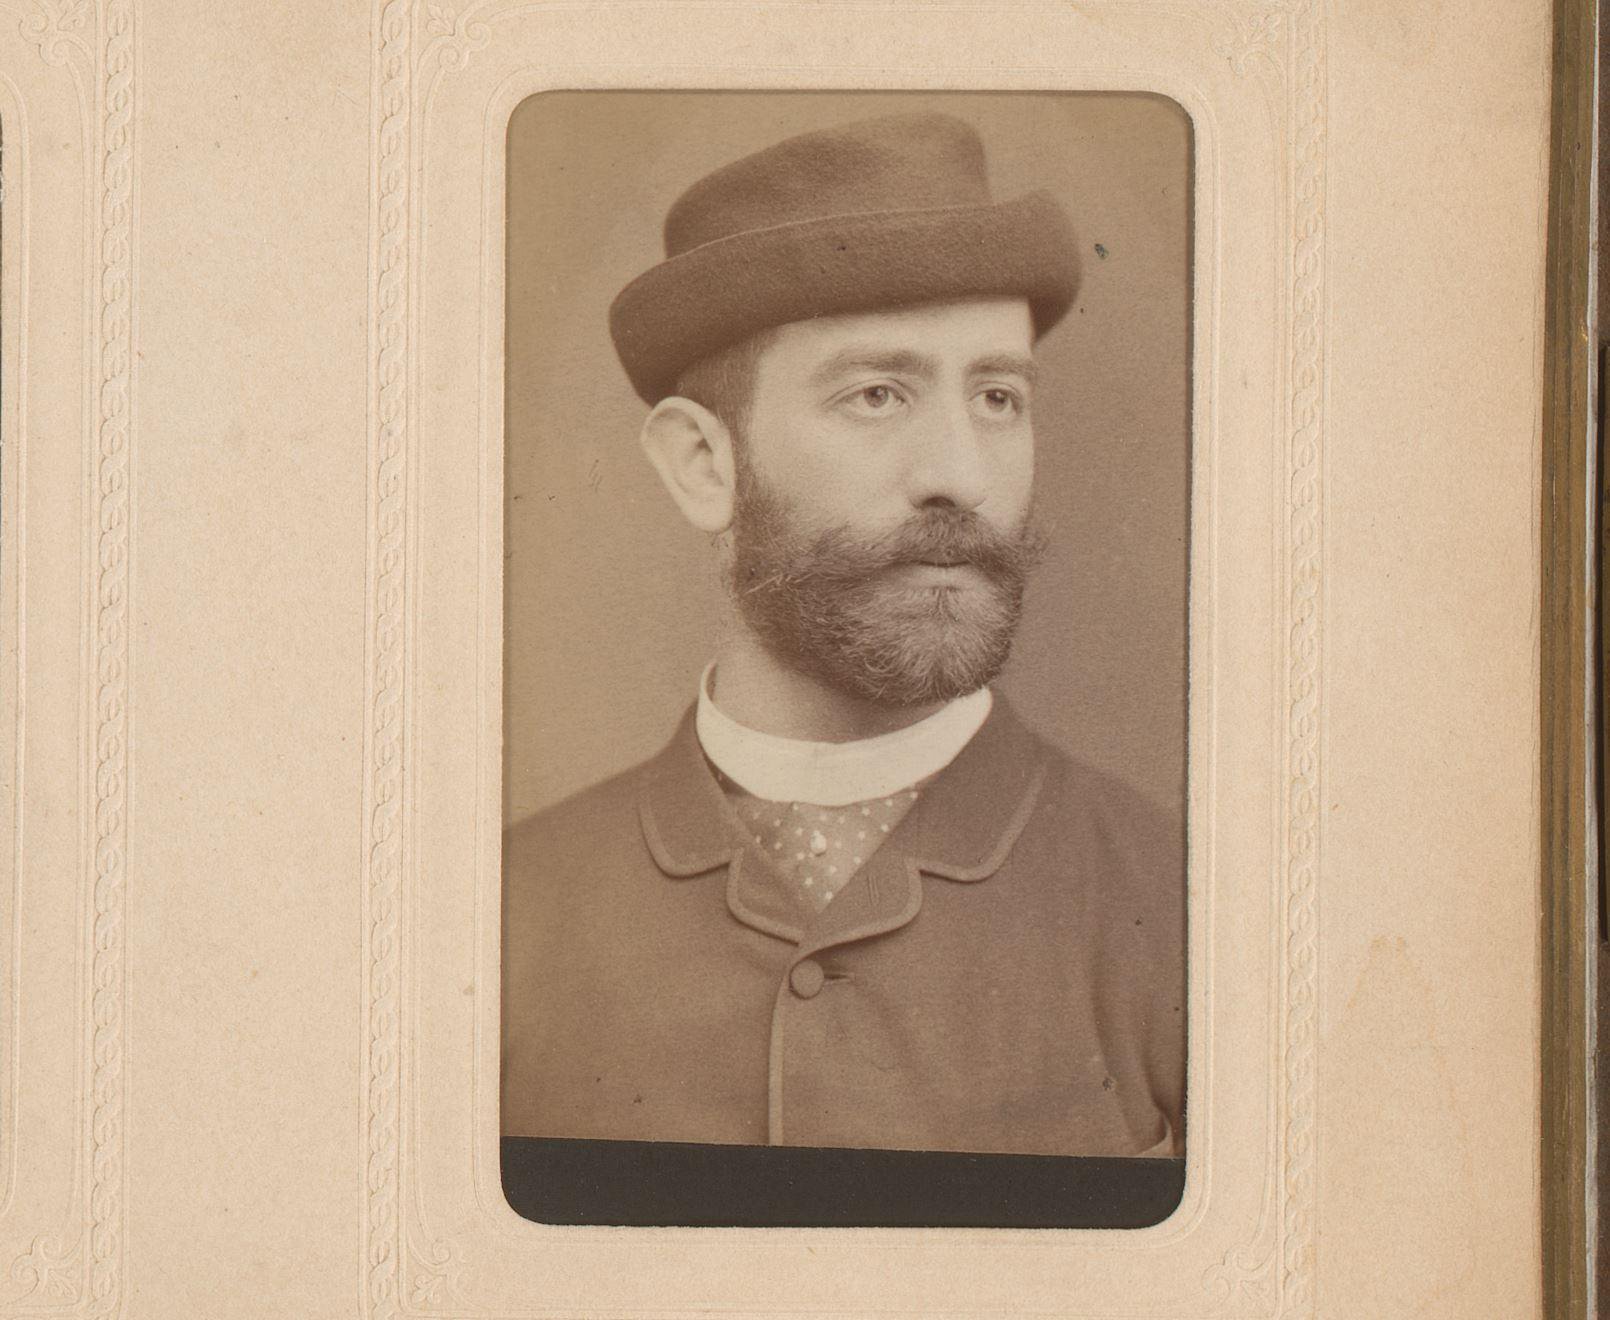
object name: carte de visite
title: Portret van een man met snor, baard en hoed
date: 1860-1900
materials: cardboard, photographic support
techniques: albumen print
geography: prague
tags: moustache, historical persons, head-gear: hat, beard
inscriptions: inscription: ‘VIRIBUS UNITIS/ C.K. DVORNI KAIS. KÖN. HOF/ FOTOGRAF/ PRAHA PRAG/ H. ECKERT & J. MÜLLERN’